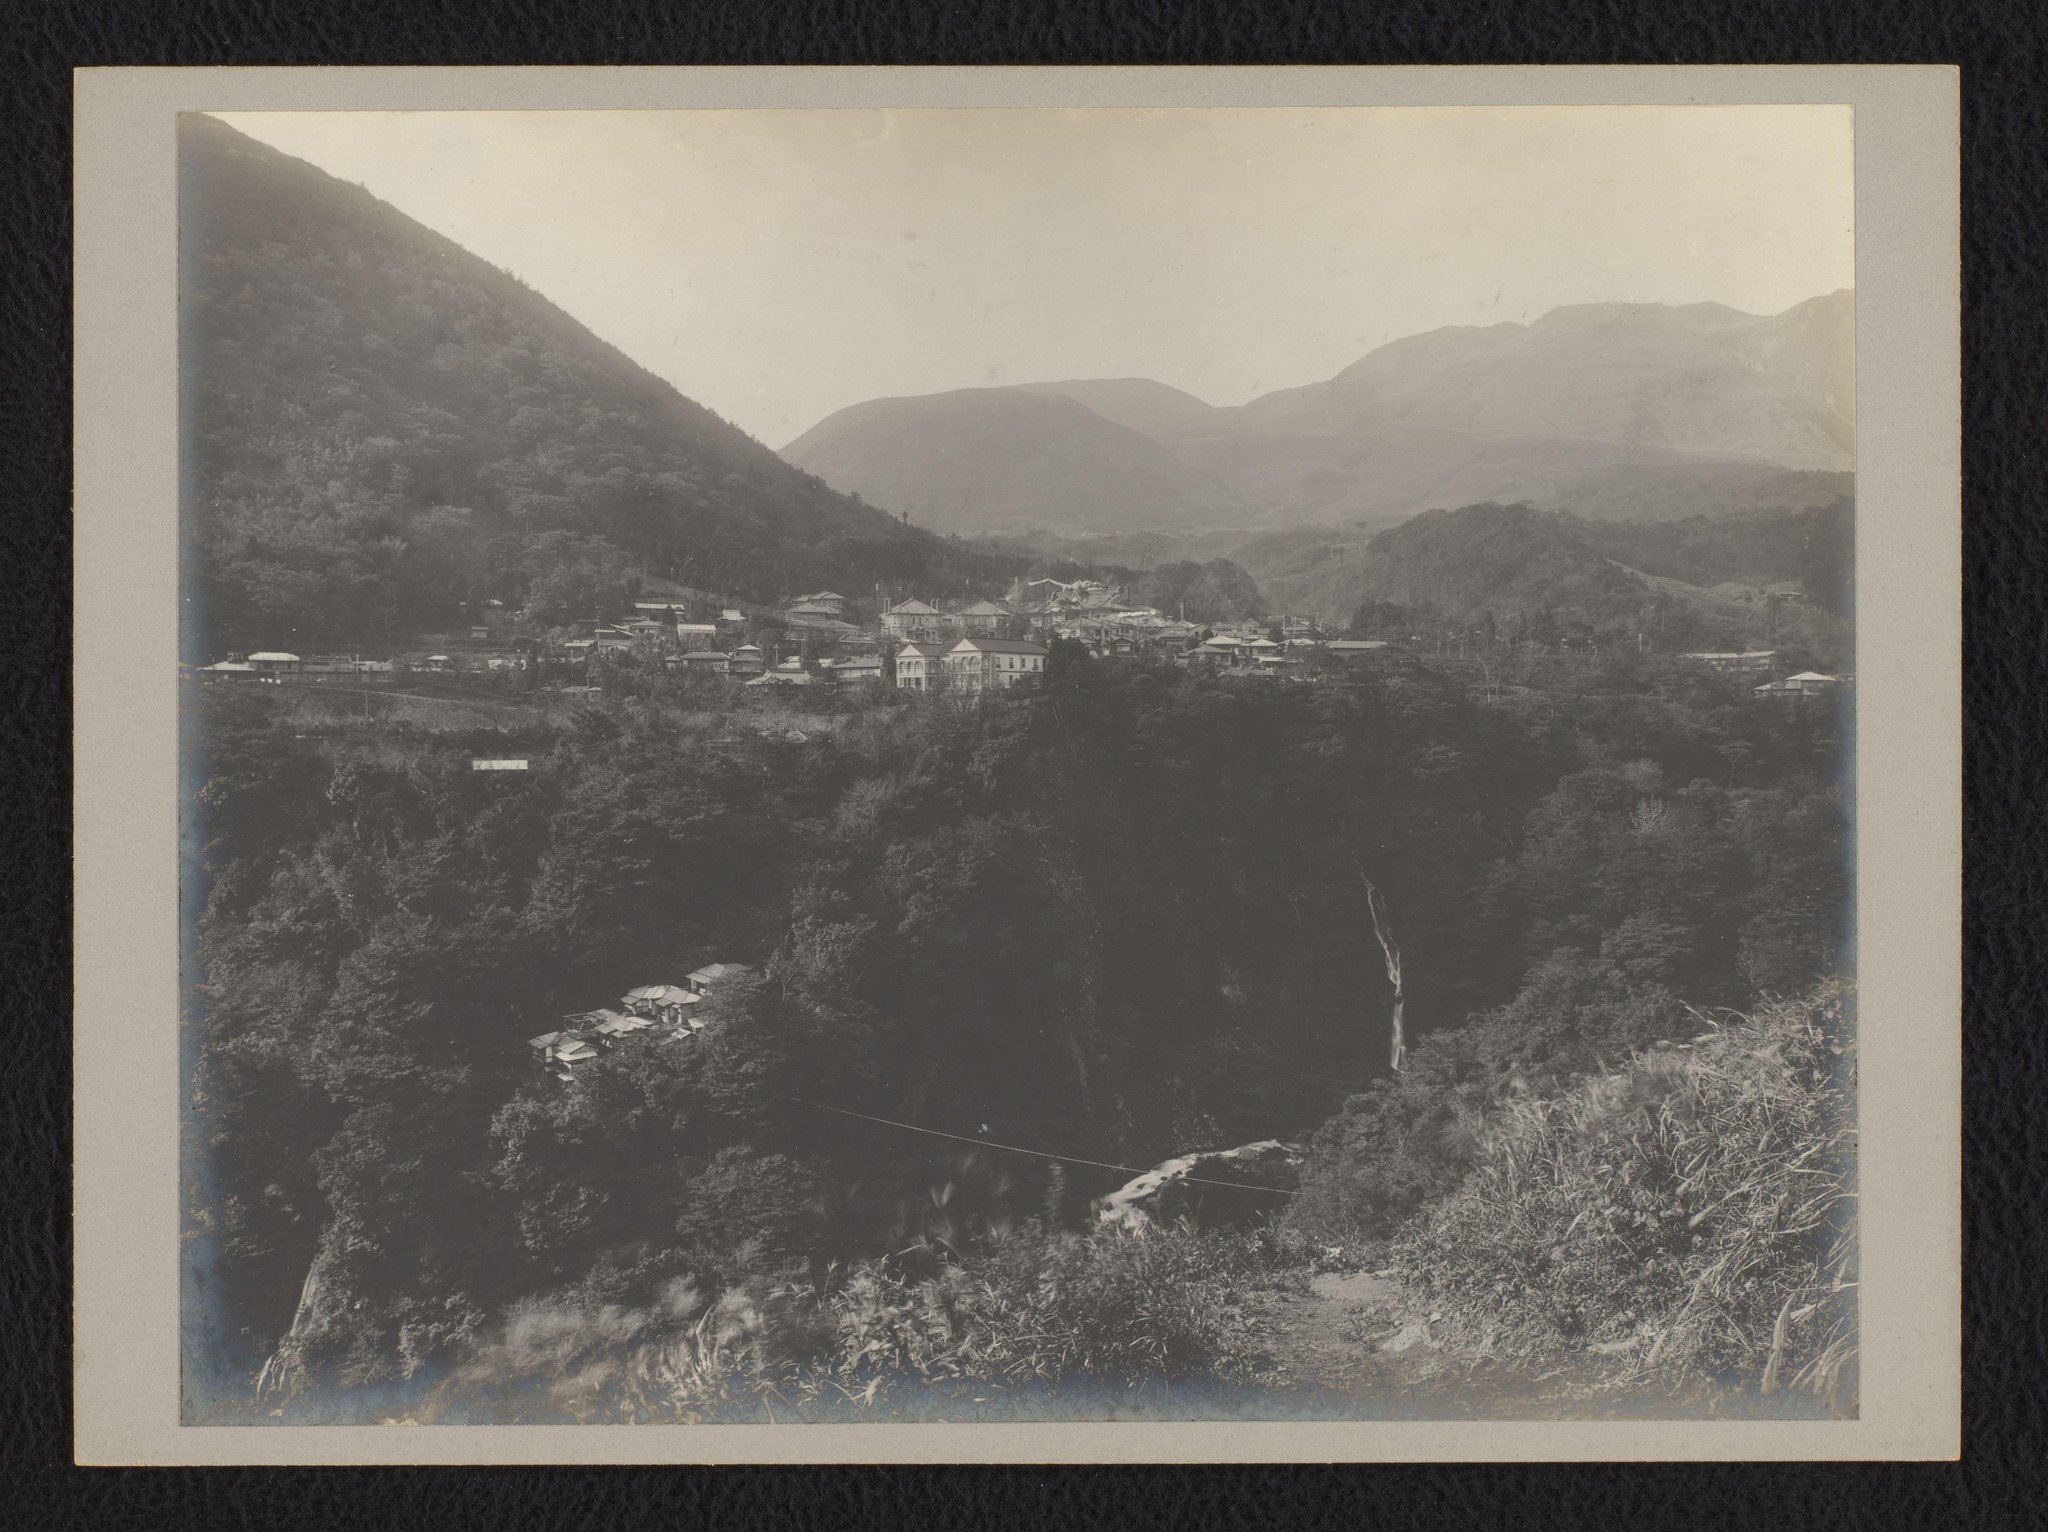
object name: photograph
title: Uitzicht op Miyanoshita, Hakone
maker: Anonymous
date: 1895-1915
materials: cardboard, photographic support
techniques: gelatin silver print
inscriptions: annotation: ‘17. Miyanoshita’